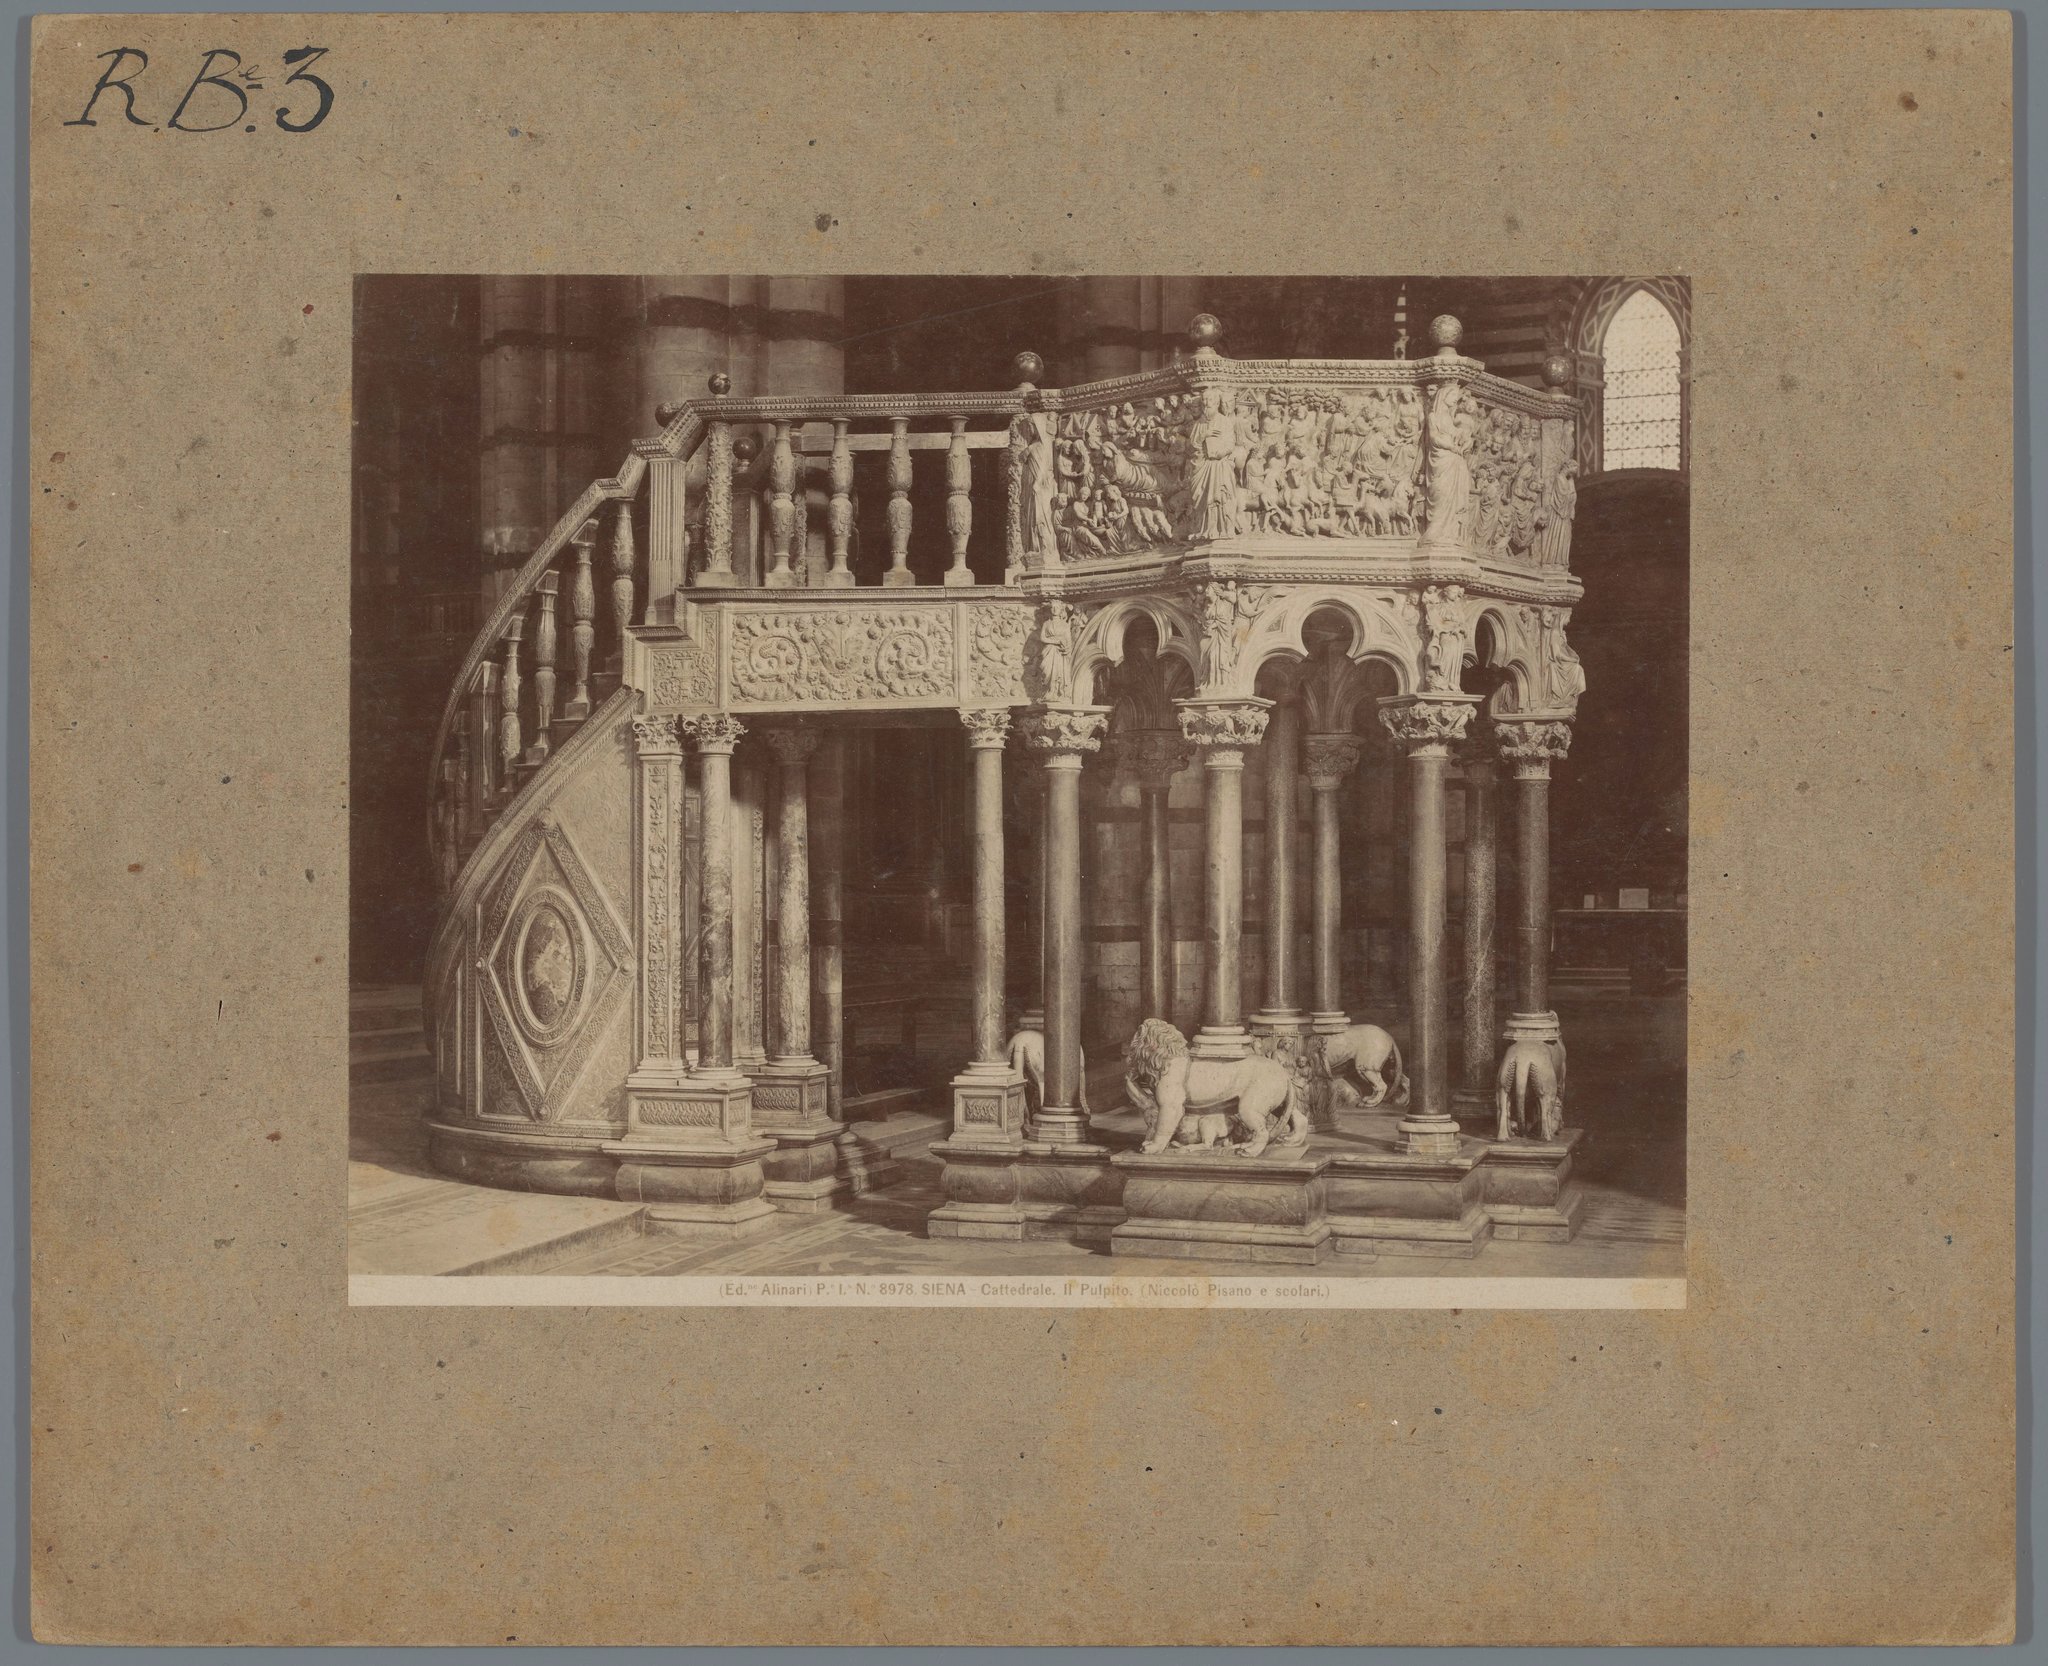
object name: photograph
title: Preekstoel in de Dom van Siena door Nicola Pisano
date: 1875-1900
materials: cardboard, photographic support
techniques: albumen print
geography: siena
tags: pulpit, ambo, chancel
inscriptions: inscription: ‘R.B-. 3’, number: ‘P.e I.a N.o 8978.’, collector's mark: Lugt 3937